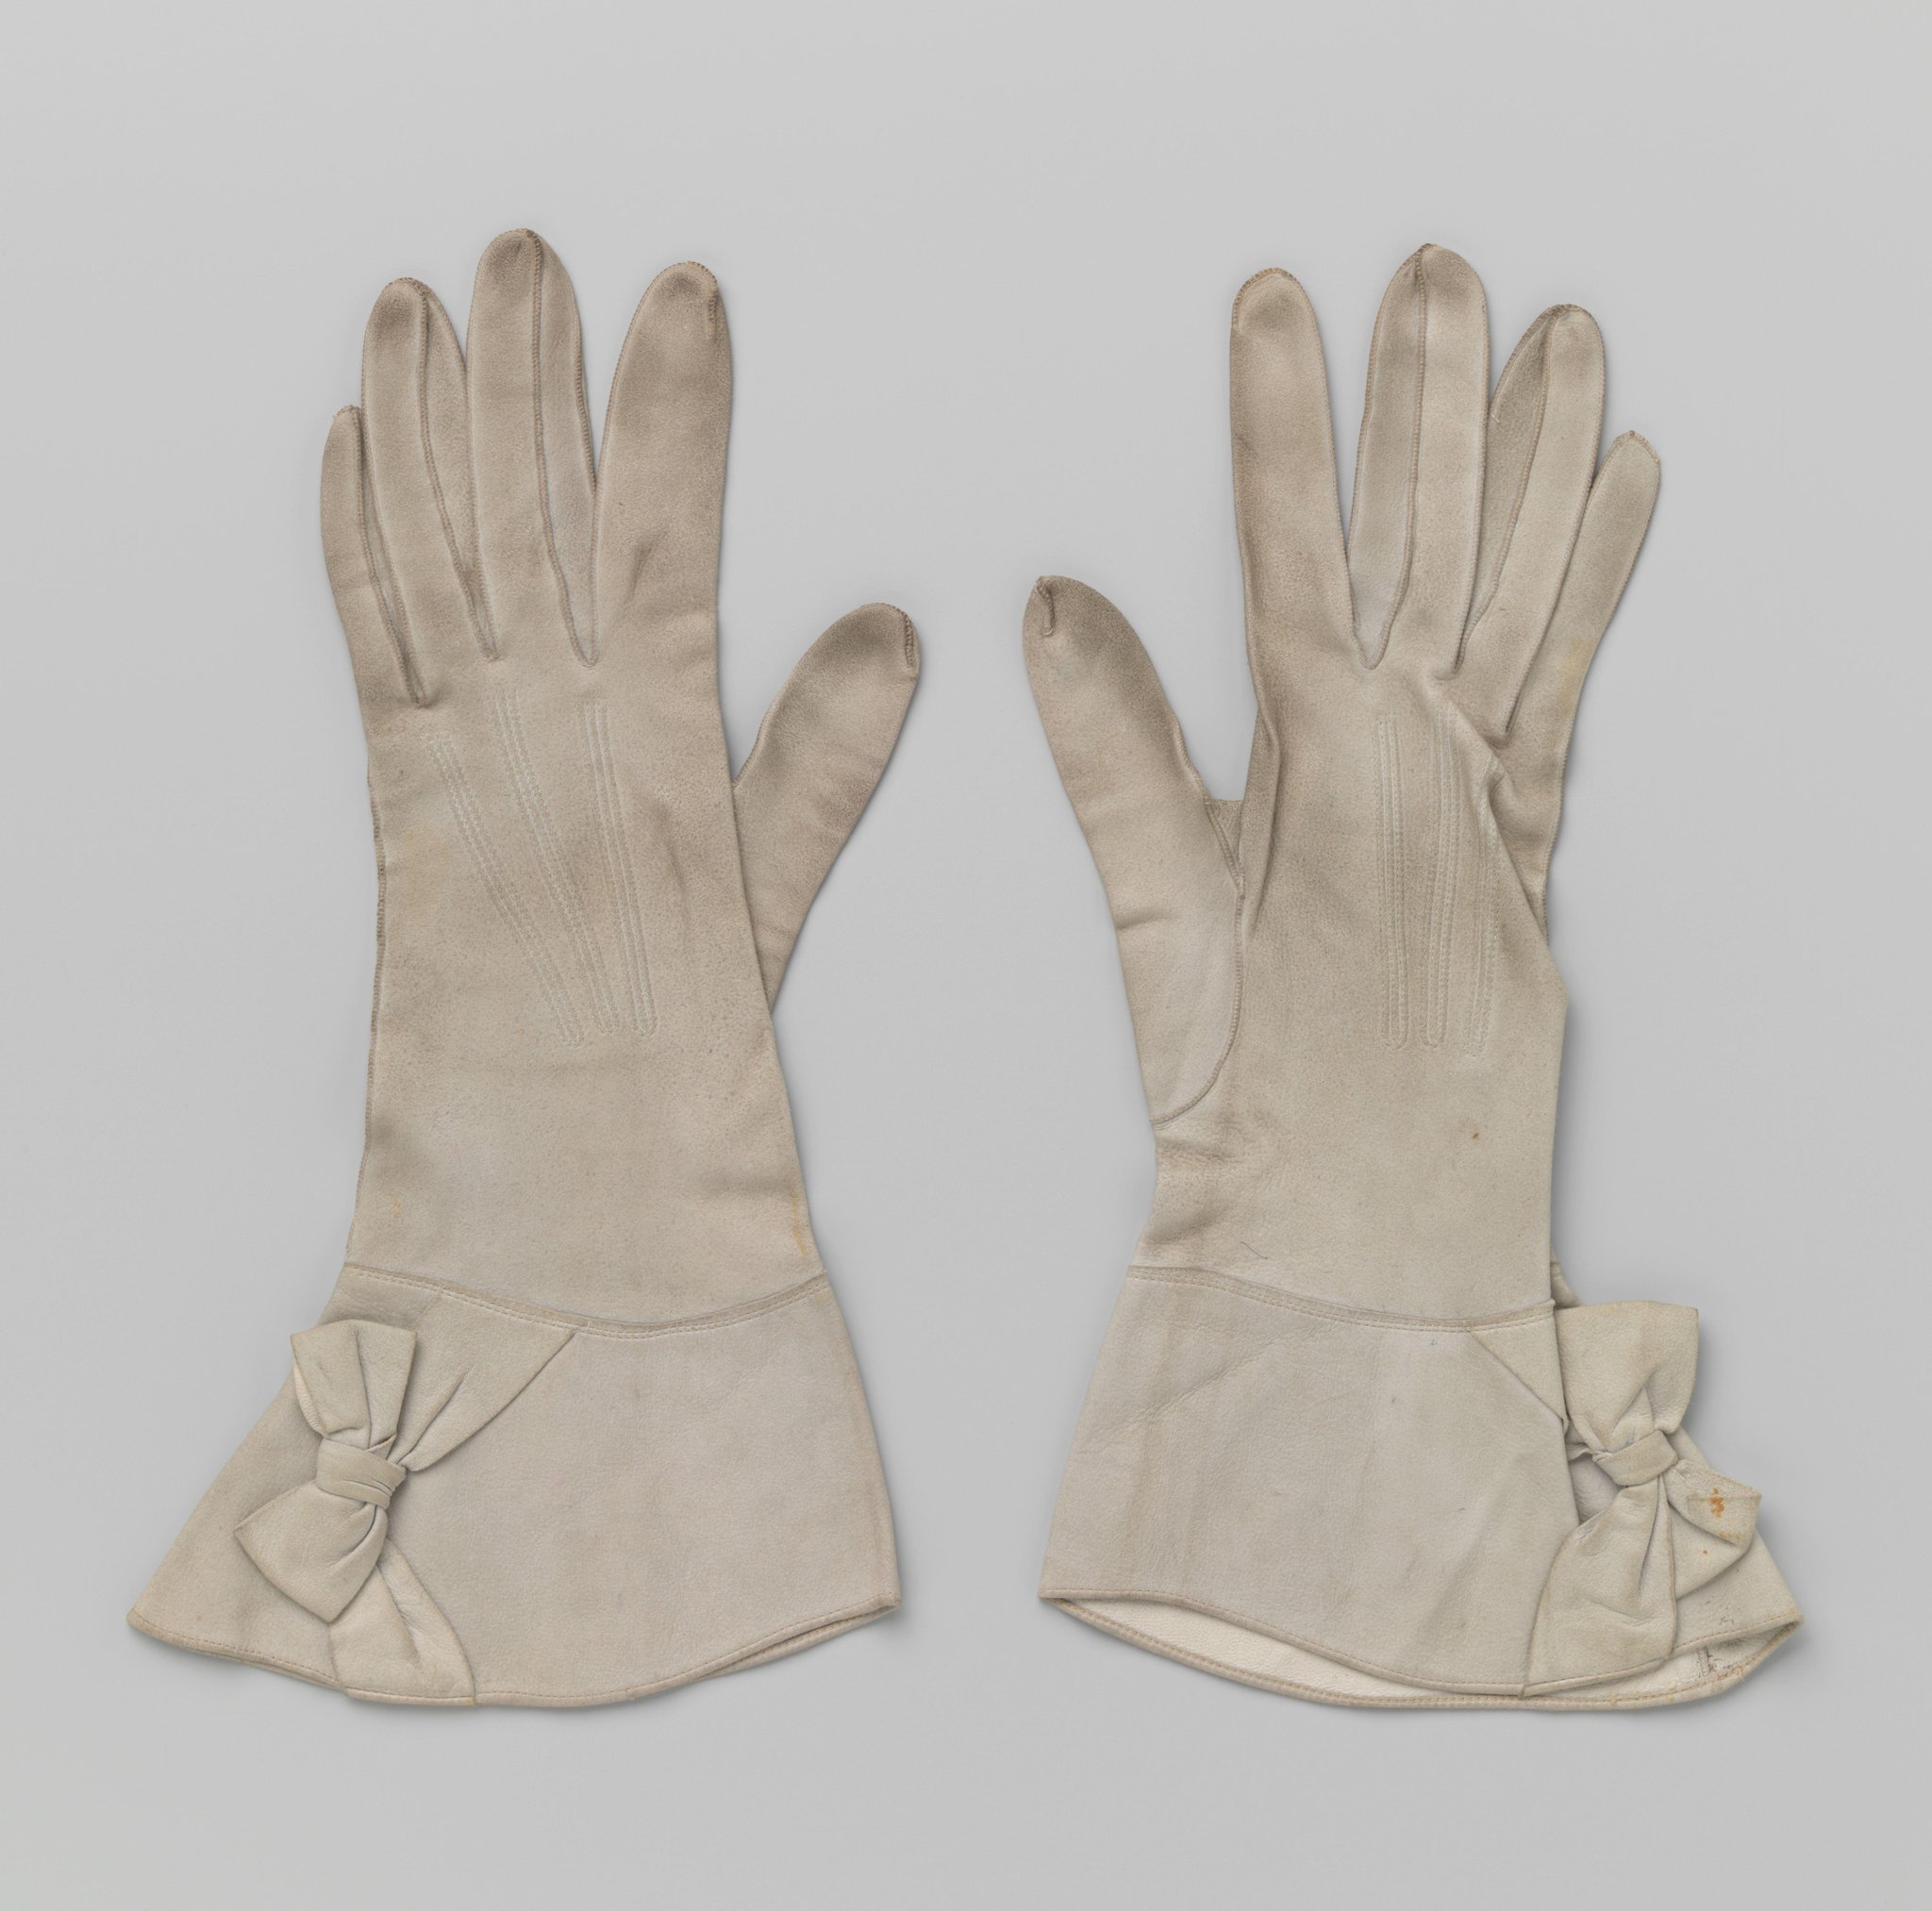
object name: glove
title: Handschoen van grijze suède, met kappen met een suède strik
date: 1930-1940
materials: leather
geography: netherlands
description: Rechterhandschoen van muisgrijs suède, met kappen waarop een suède strik. Op de rug drie koorden.